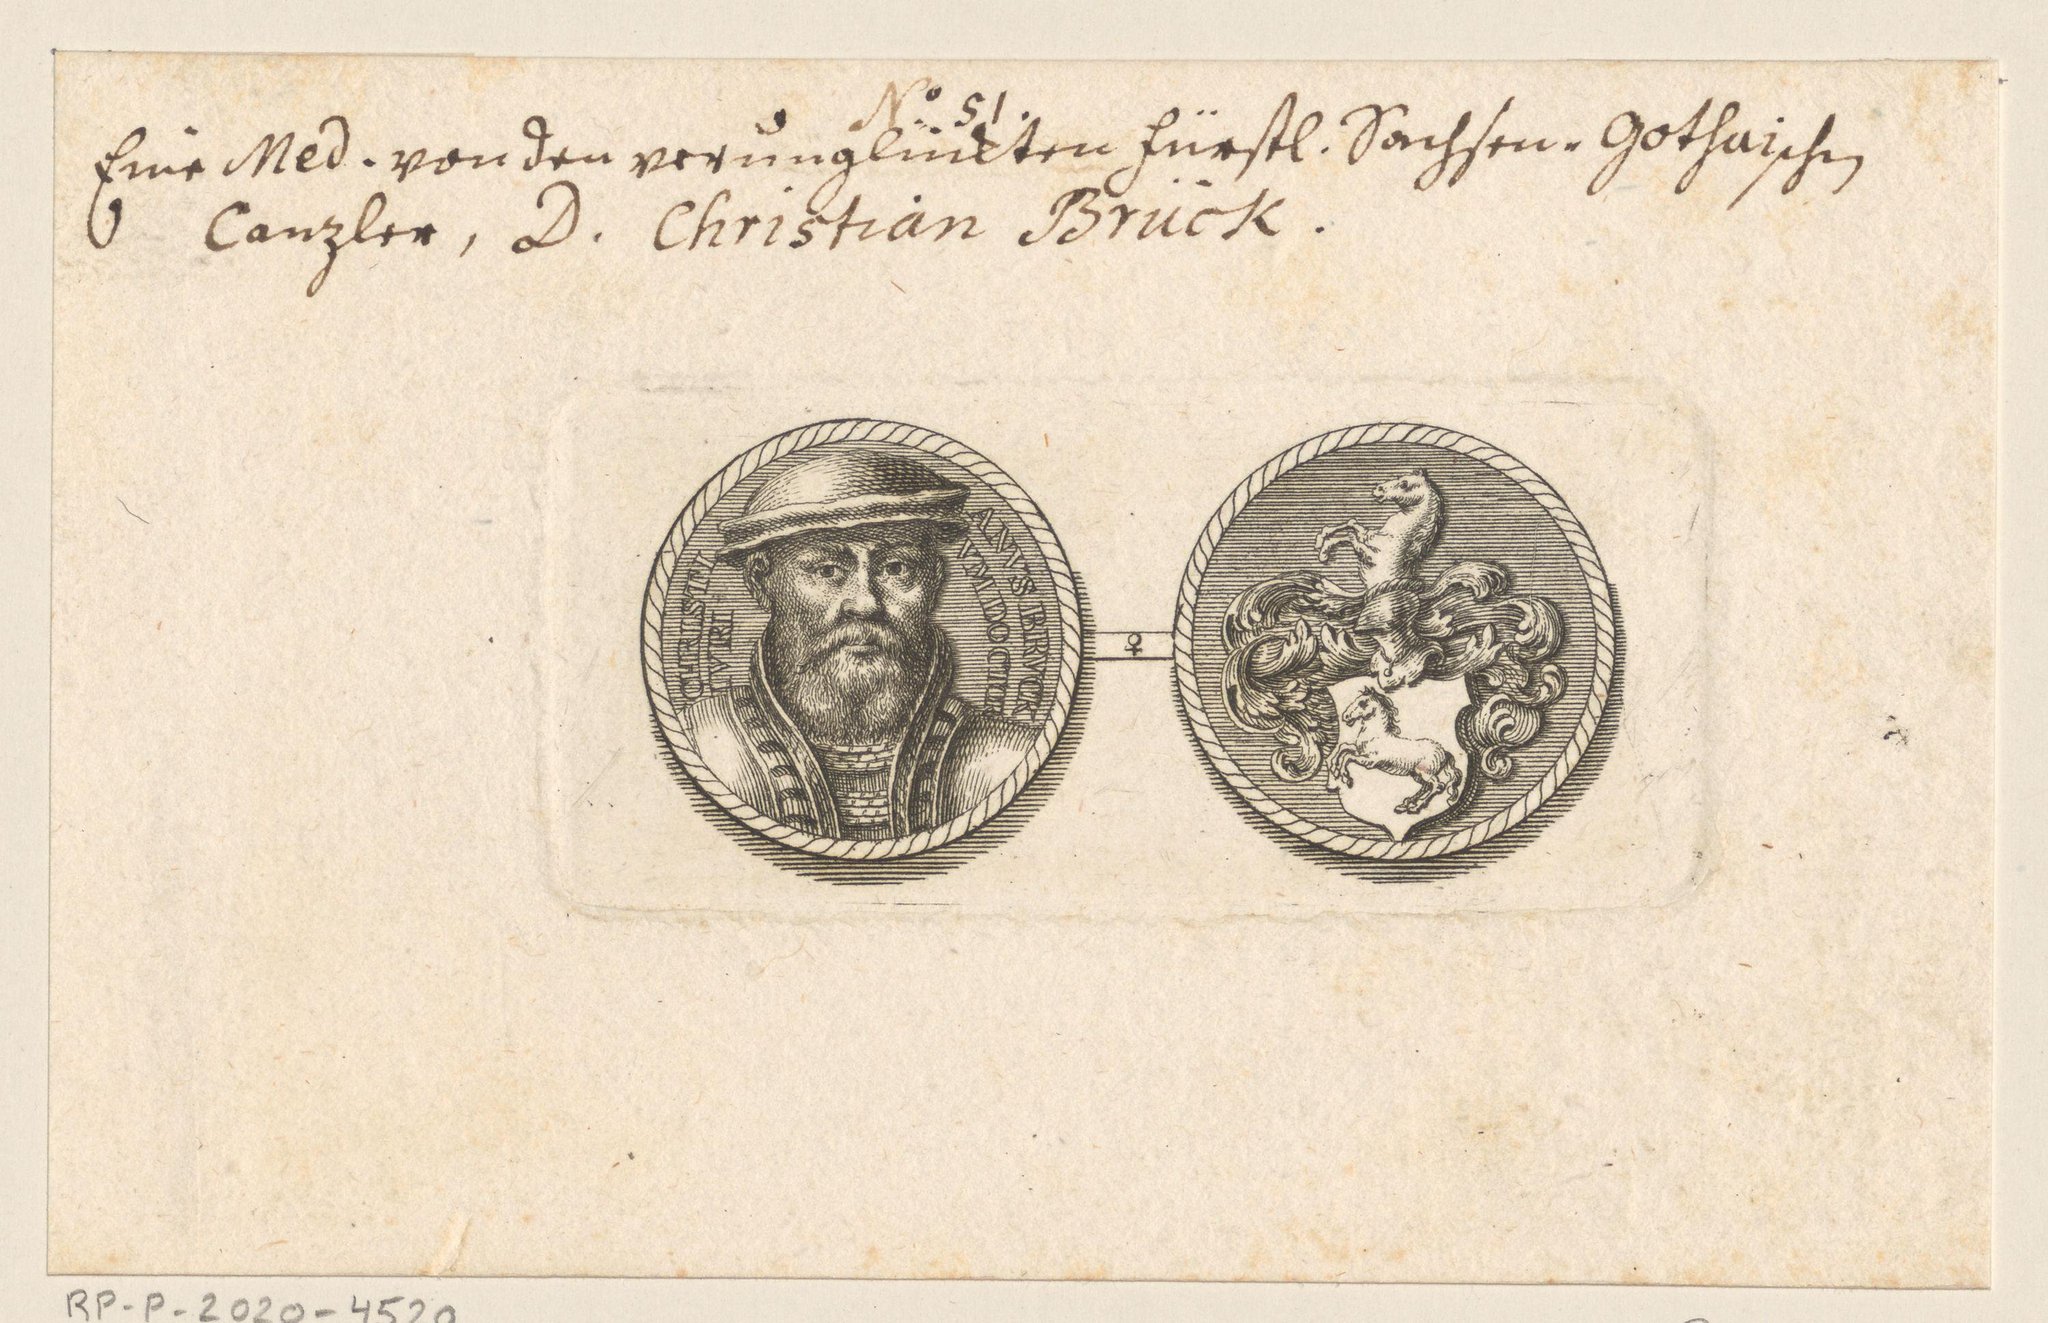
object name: print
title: Penning met portret en wapenschild van Christian Brück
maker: Anonymous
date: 1740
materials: paper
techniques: etching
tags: historical persons, medal (considered as a piece of sculpture, regardless of its specific function), armorial bearing, heraldry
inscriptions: inscription: ‘No. 51/ [...]/ Canzler, D. Christian Brück’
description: Prent met tekst op recto en verso gebruikt in: Köhler, Johann David. Historische Münz-Belustigung (...). Neurenberg: Christoph Weigel, 1740, dl. 12.